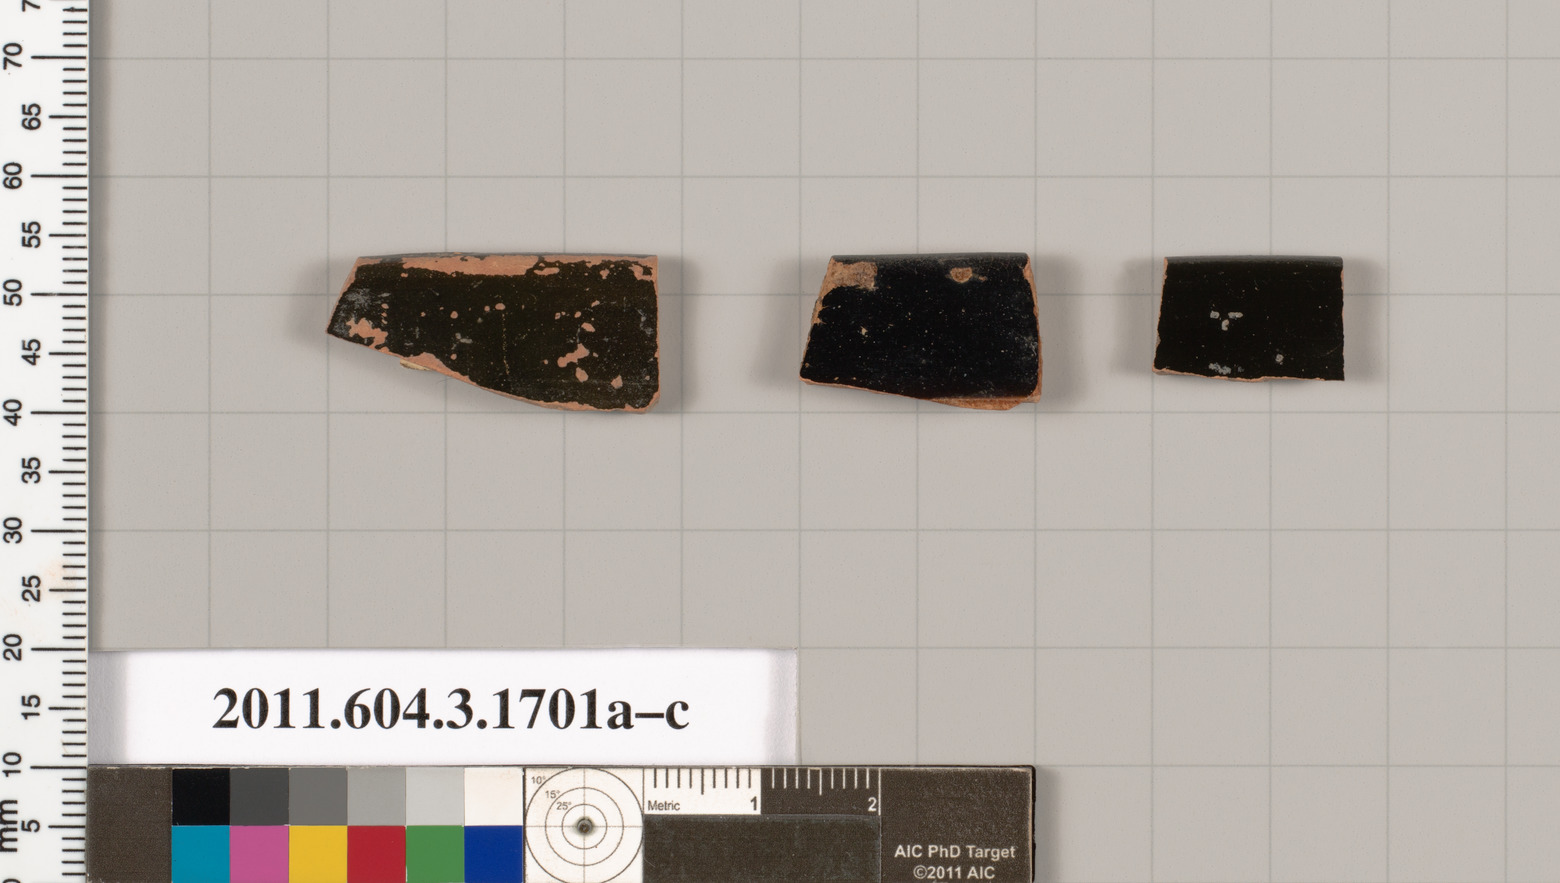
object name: kylix fragment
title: Terracotta rim fragments of kylikes: Band cups (drinking cups)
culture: greek, attic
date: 550-526 BCE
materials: terracotta